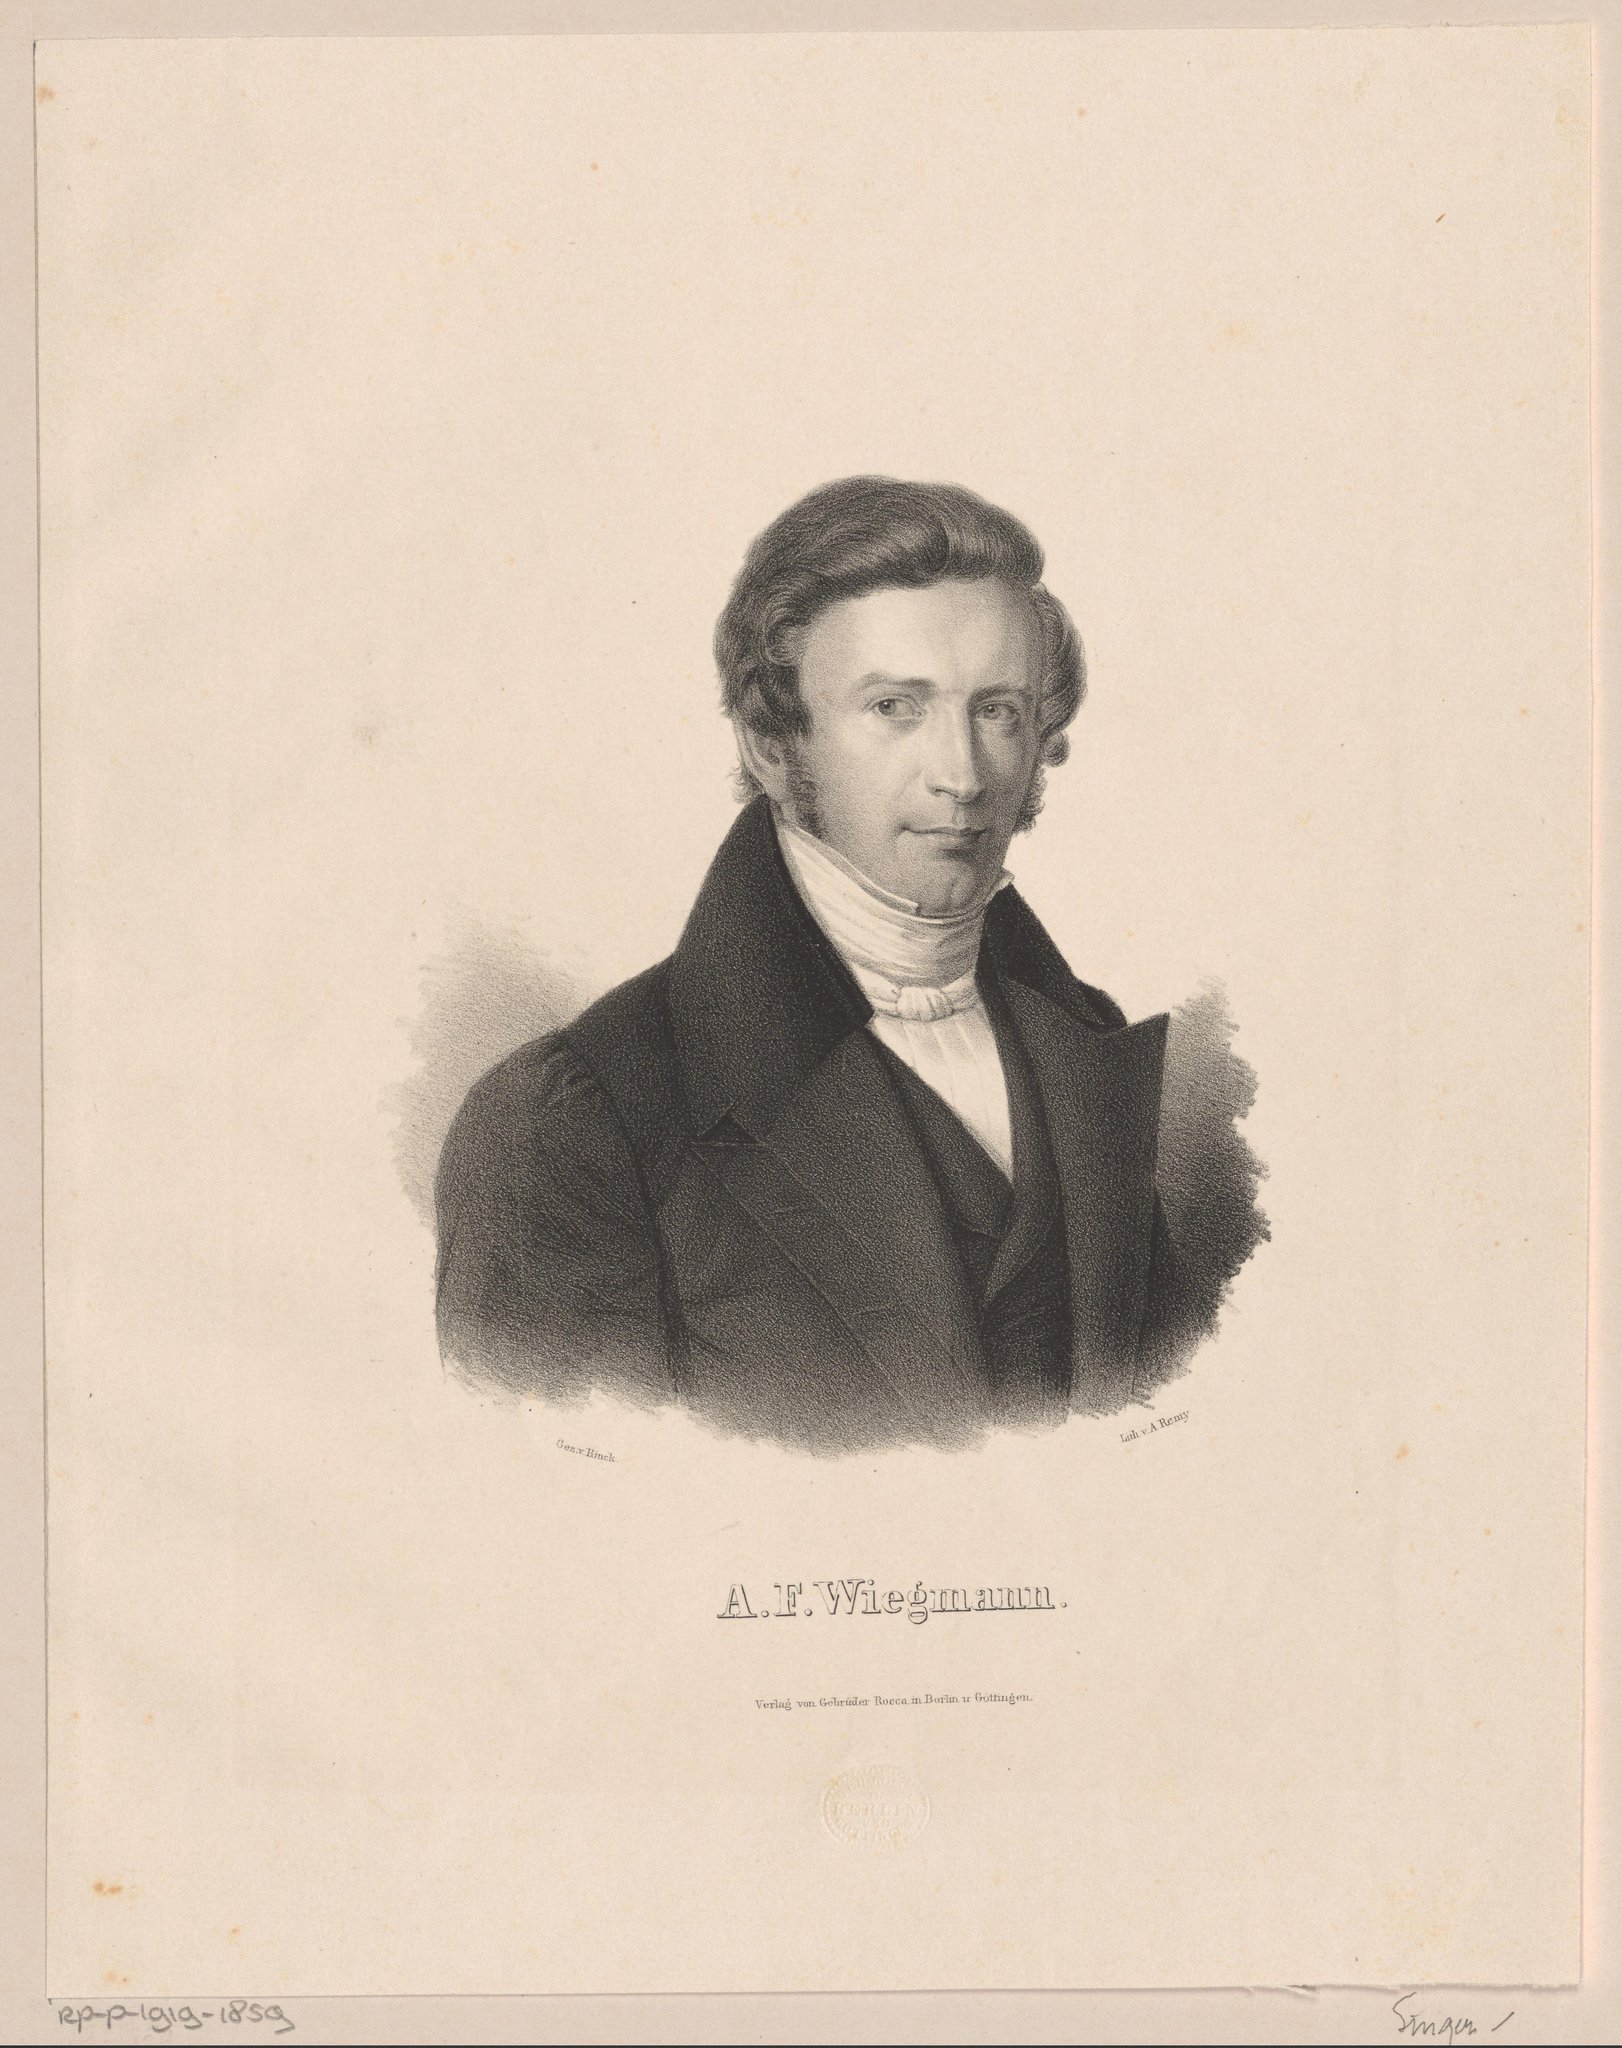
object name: print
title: Portret van Arend Friedrich August Wiegmann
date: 1830-1863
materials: paper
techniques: lithograph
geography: gottingen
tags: historical persons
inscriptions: check stamp: Lugt 5514, collector's mark: Lugt 2228